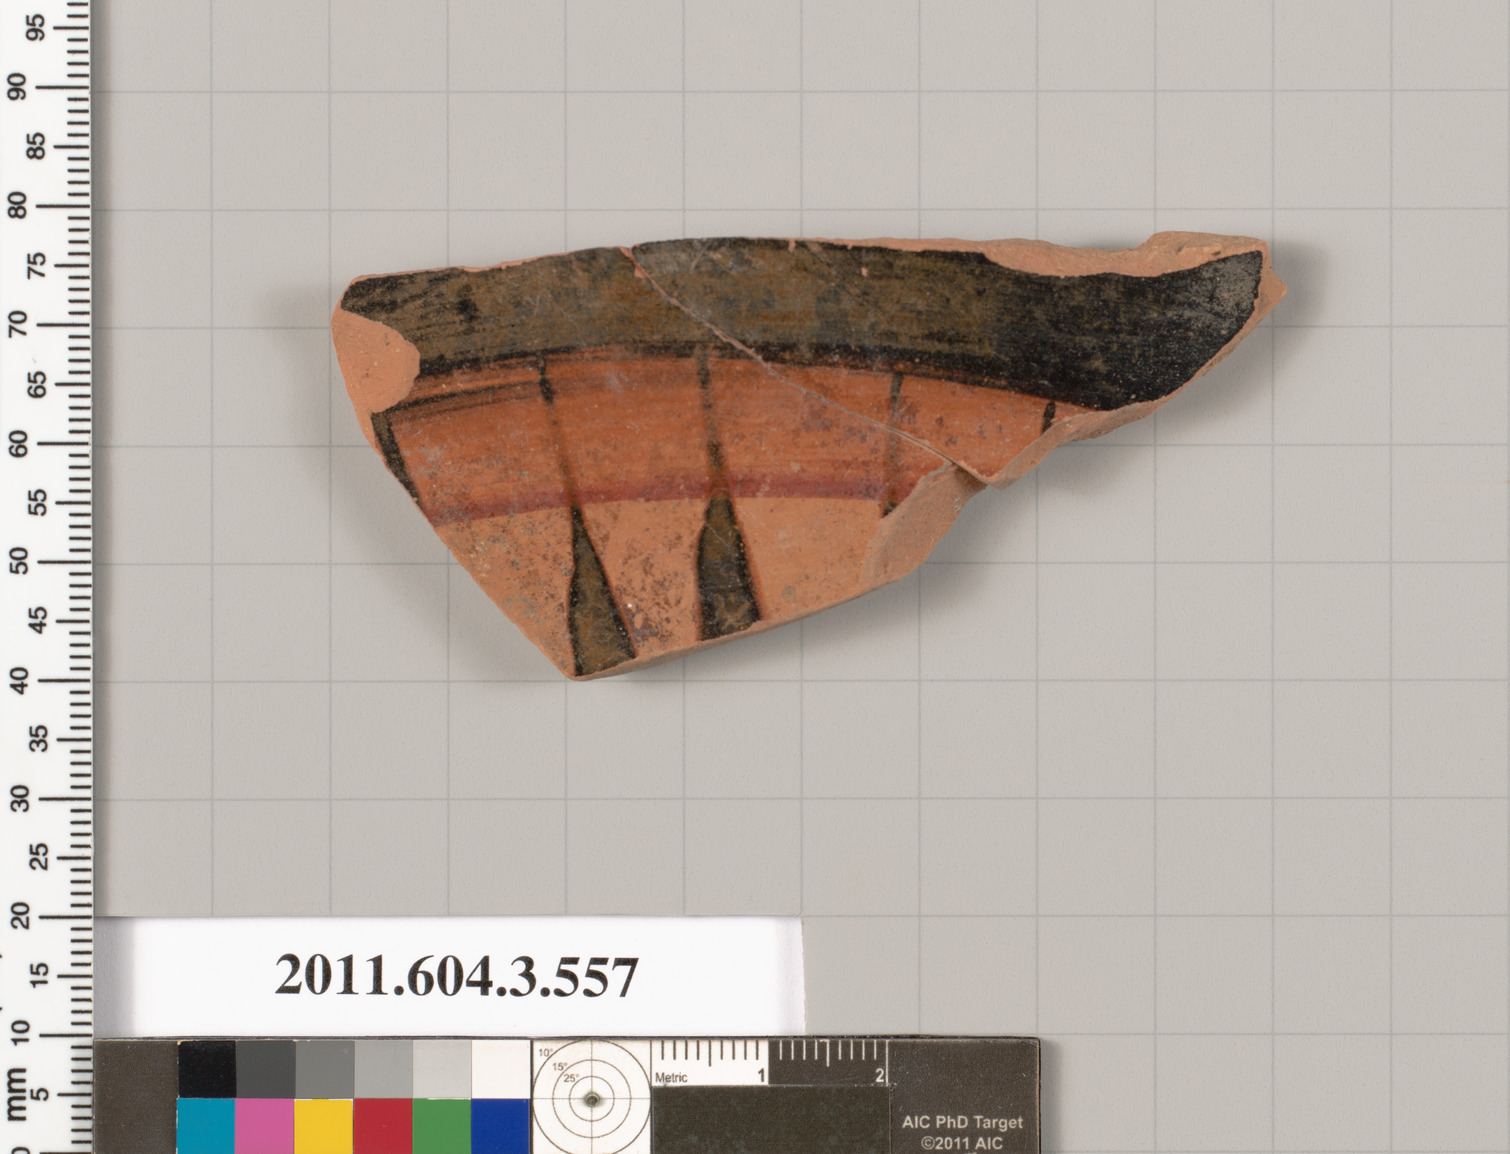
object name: column krater fragment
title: Terracotta fragment of a column-krater (bowl for mixing wine and water)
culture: greek, attic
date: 600-401 BCE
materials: terracotta